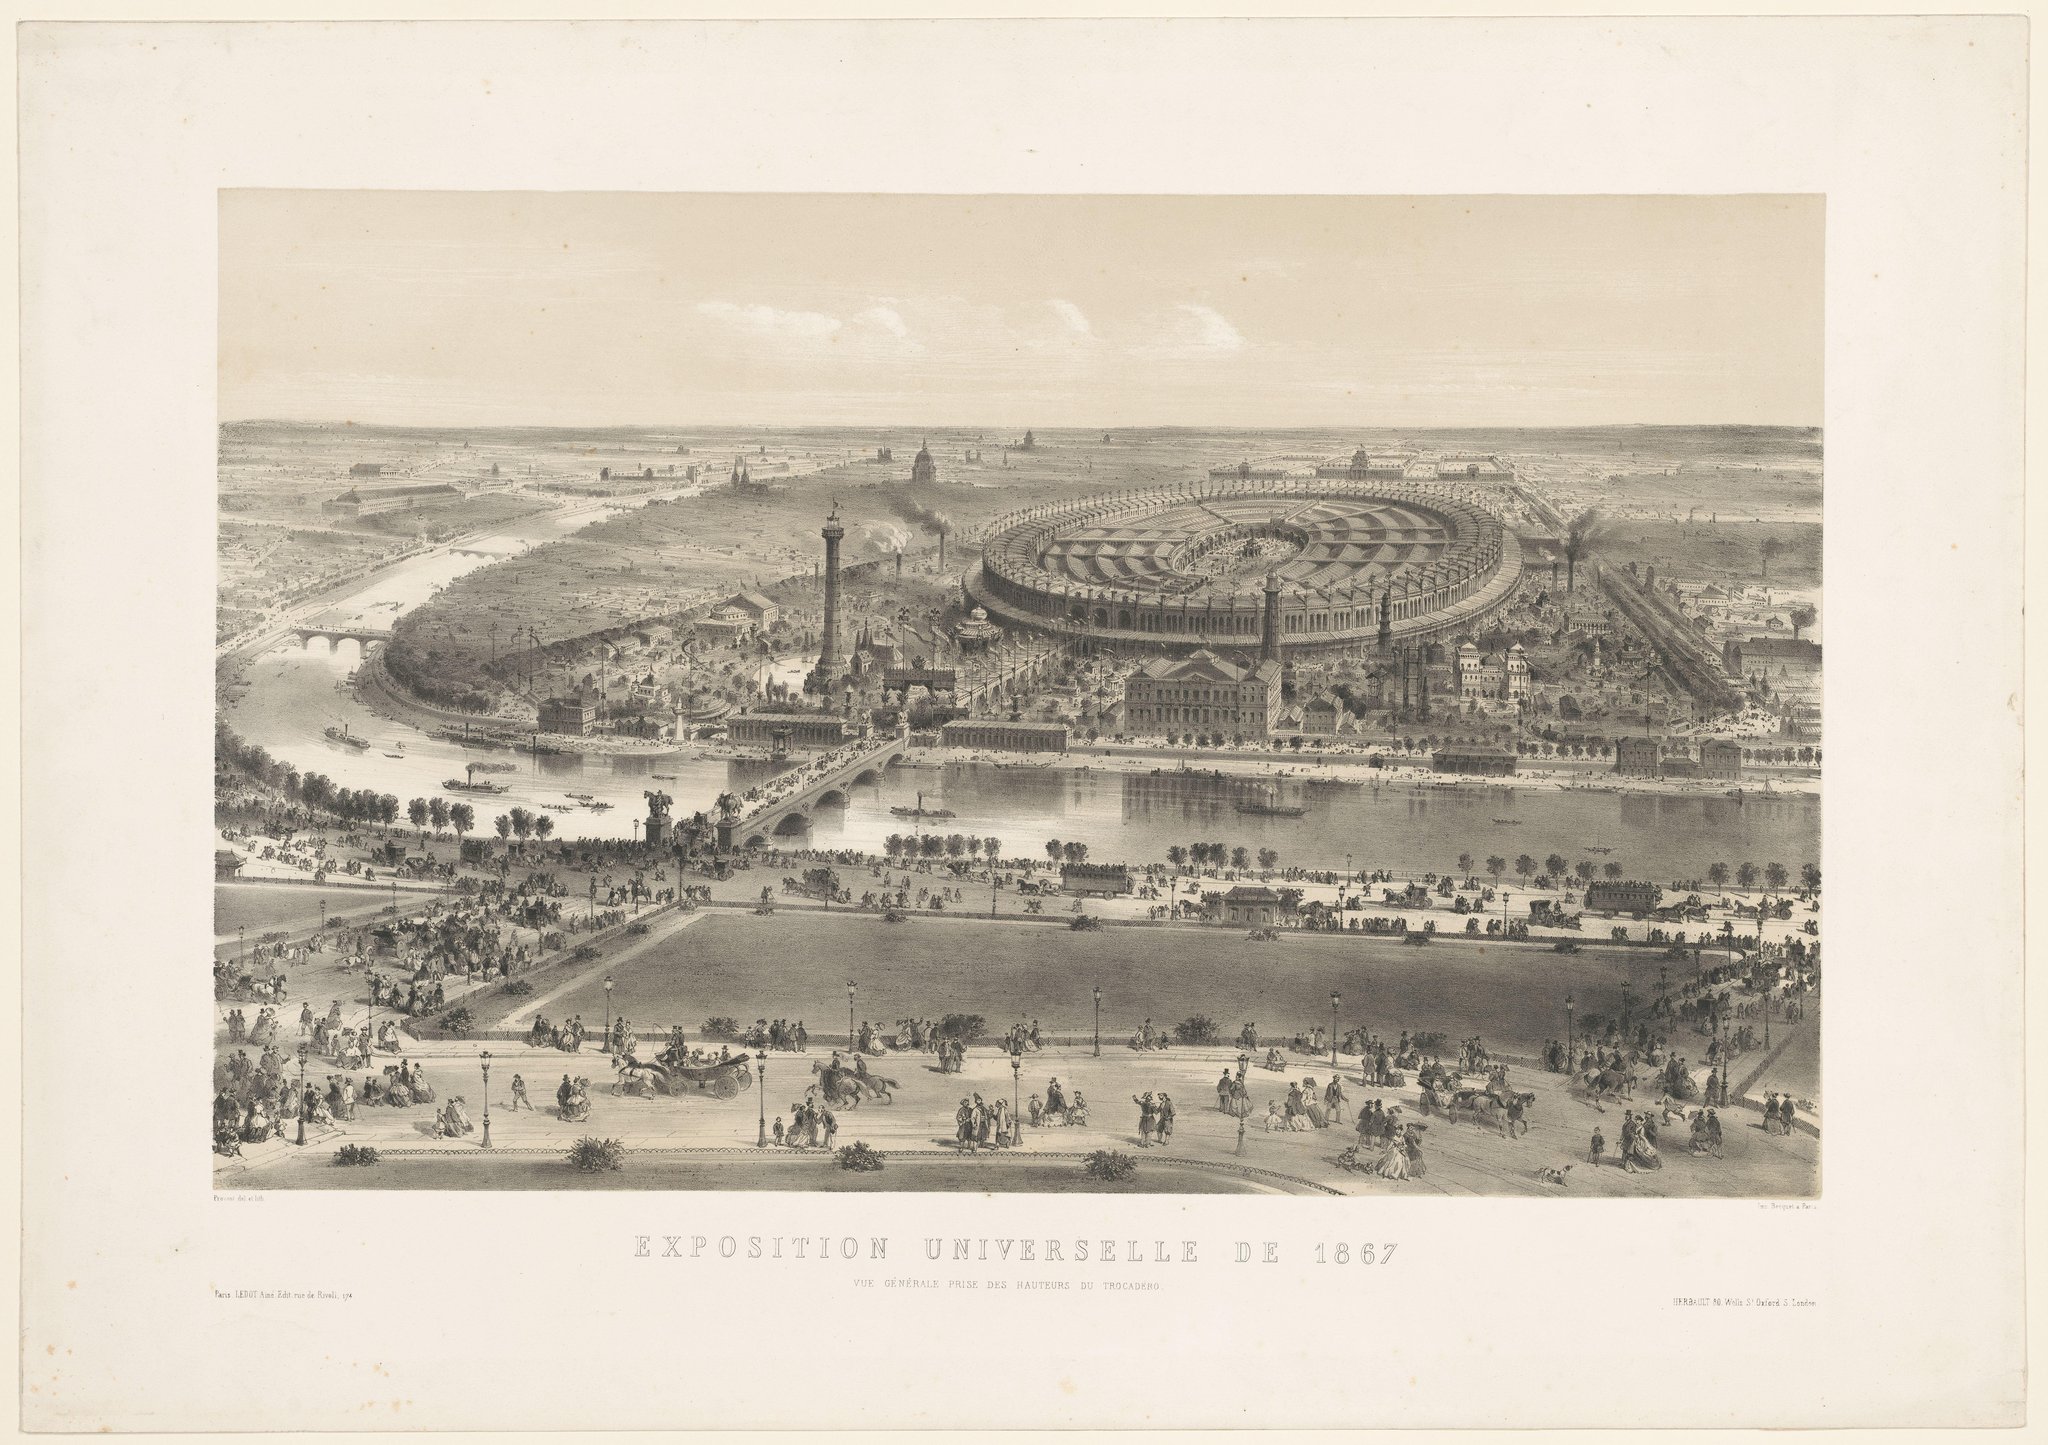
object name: print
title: Gezicht op de wereldtentoonstelling van 1867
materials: paper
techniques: tone lithography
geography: france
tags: city-view in general; 'veduta', paris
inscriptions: collector's mark: Lugt 2228